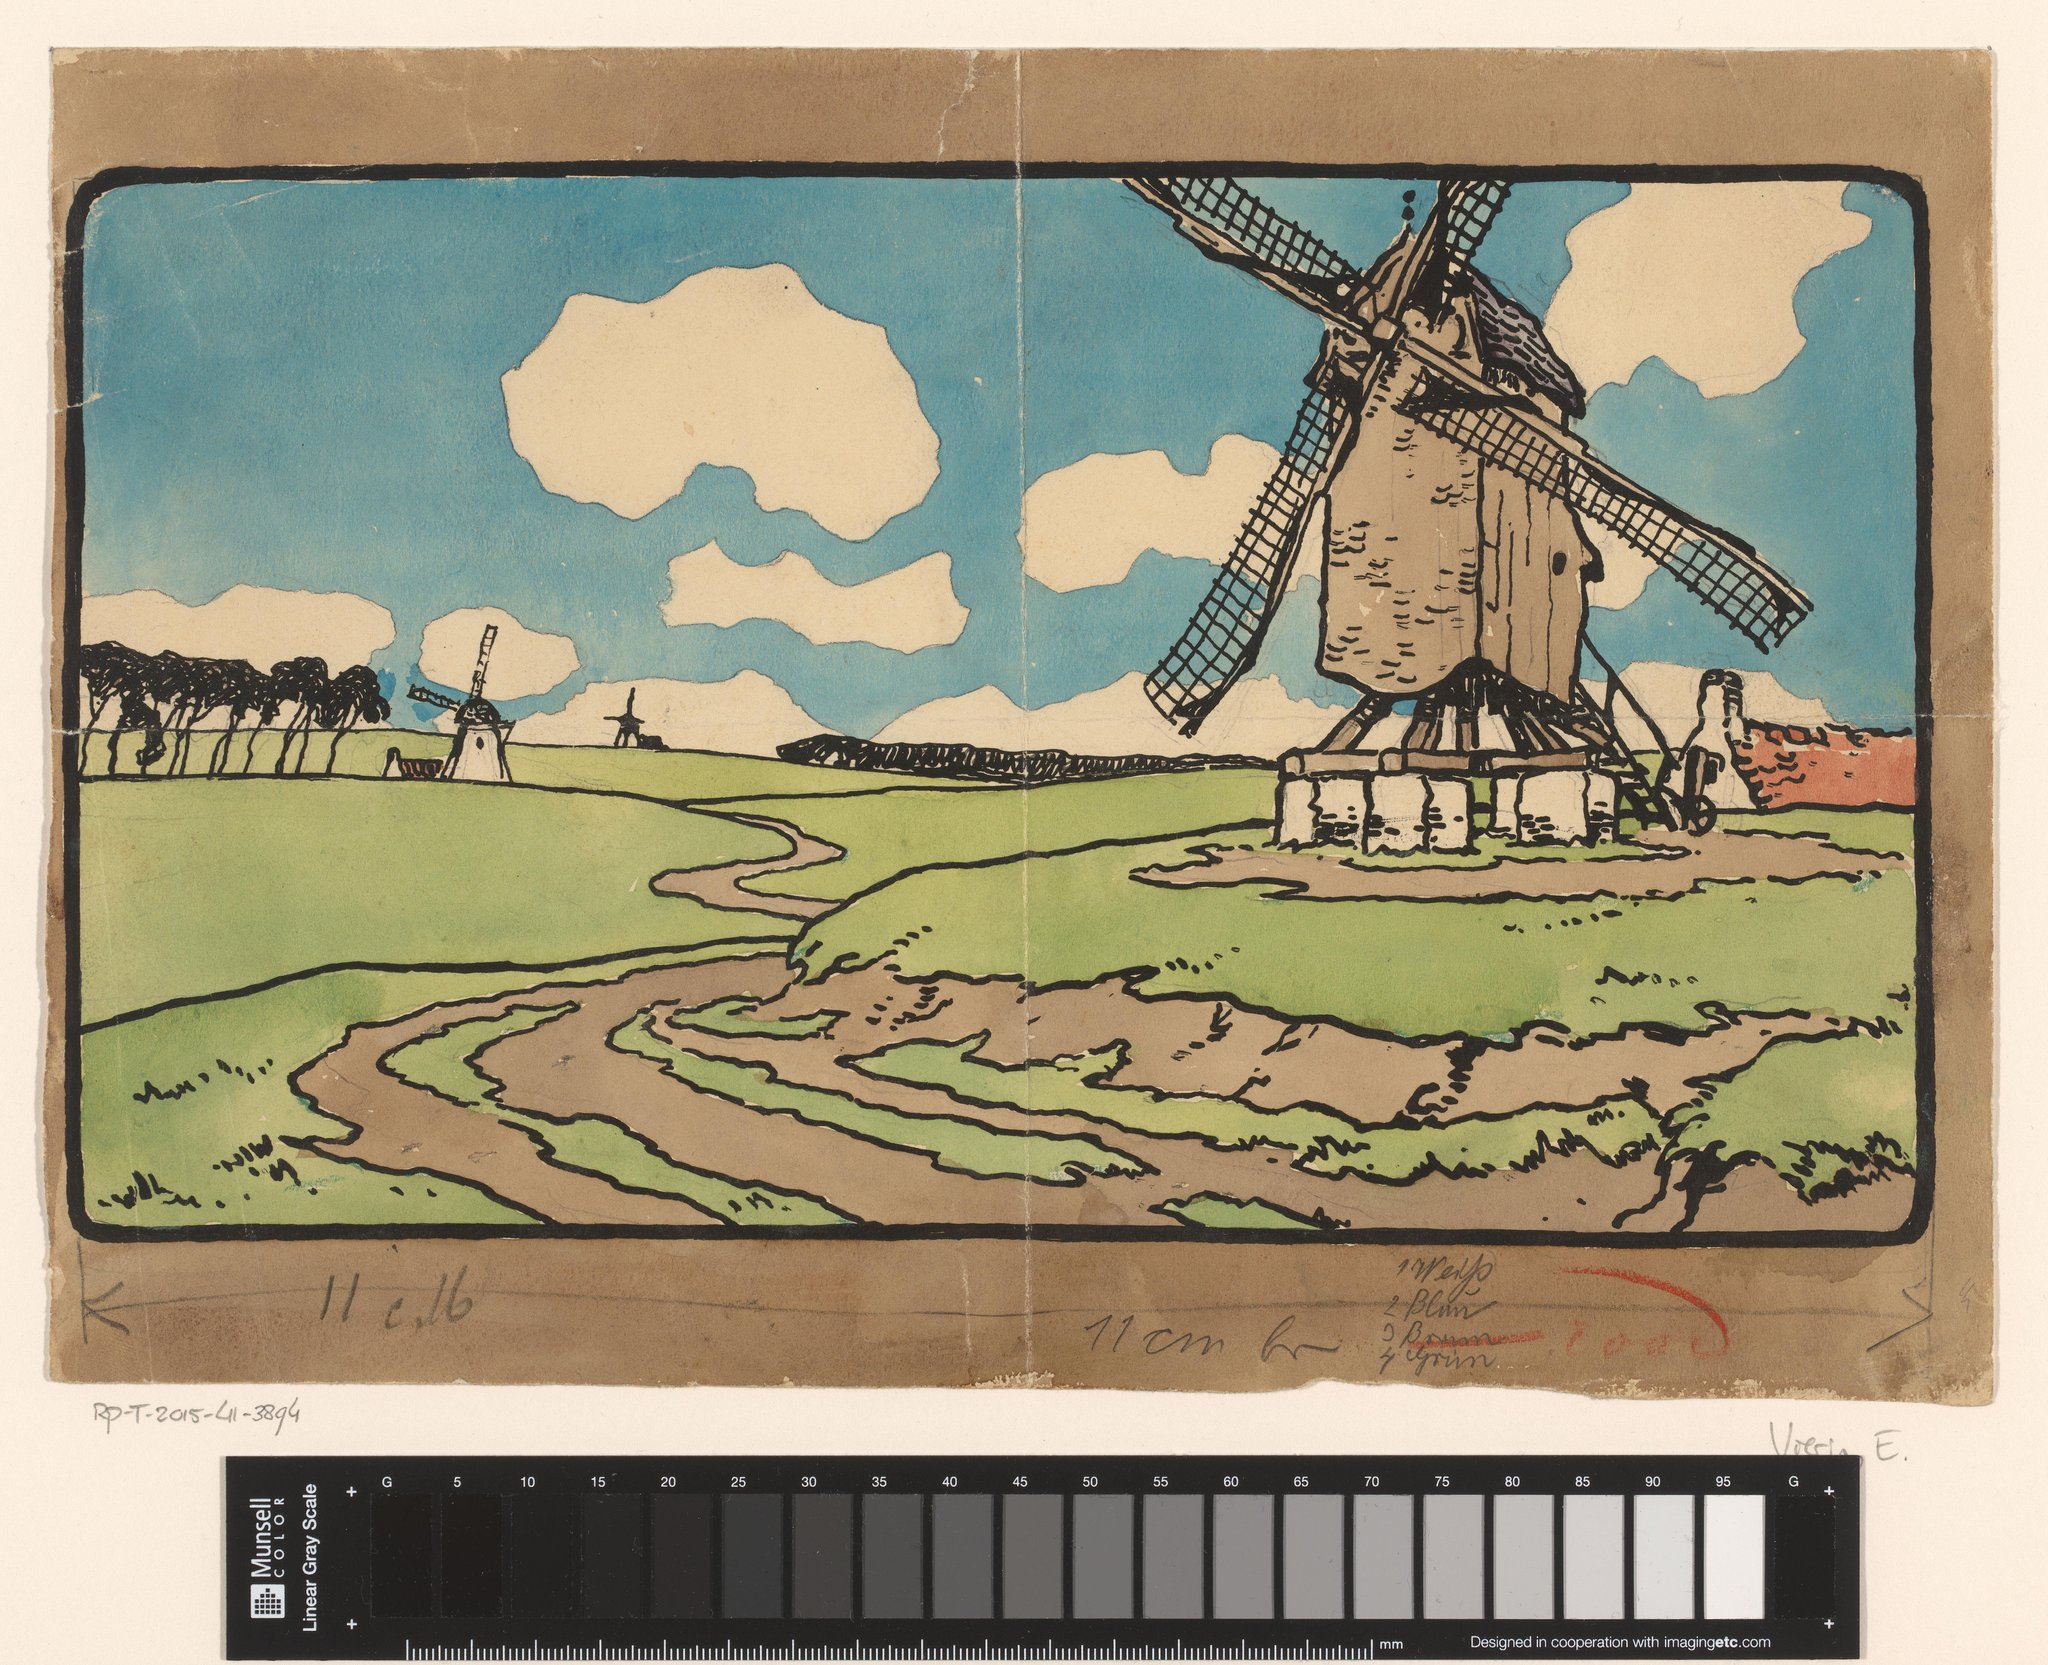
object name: boekillustratie ontwerp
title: Landschap met molens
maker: emmanuel viérin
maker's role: draughtsman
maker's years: 1869-1954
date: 1900-1920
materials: ink, paper, pencil, watercolor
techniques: brush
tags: windmill in landscape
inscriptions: :, collector's mark: Lugt 2228a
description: Vermoedelijk een ontwerp voor: Streuvels, Stijn. Lenteleven. Amsterdam: Veen, 1900 of Streuvels, Stijn. Open lucht. Amsterdam: Veen, [1905-1920].